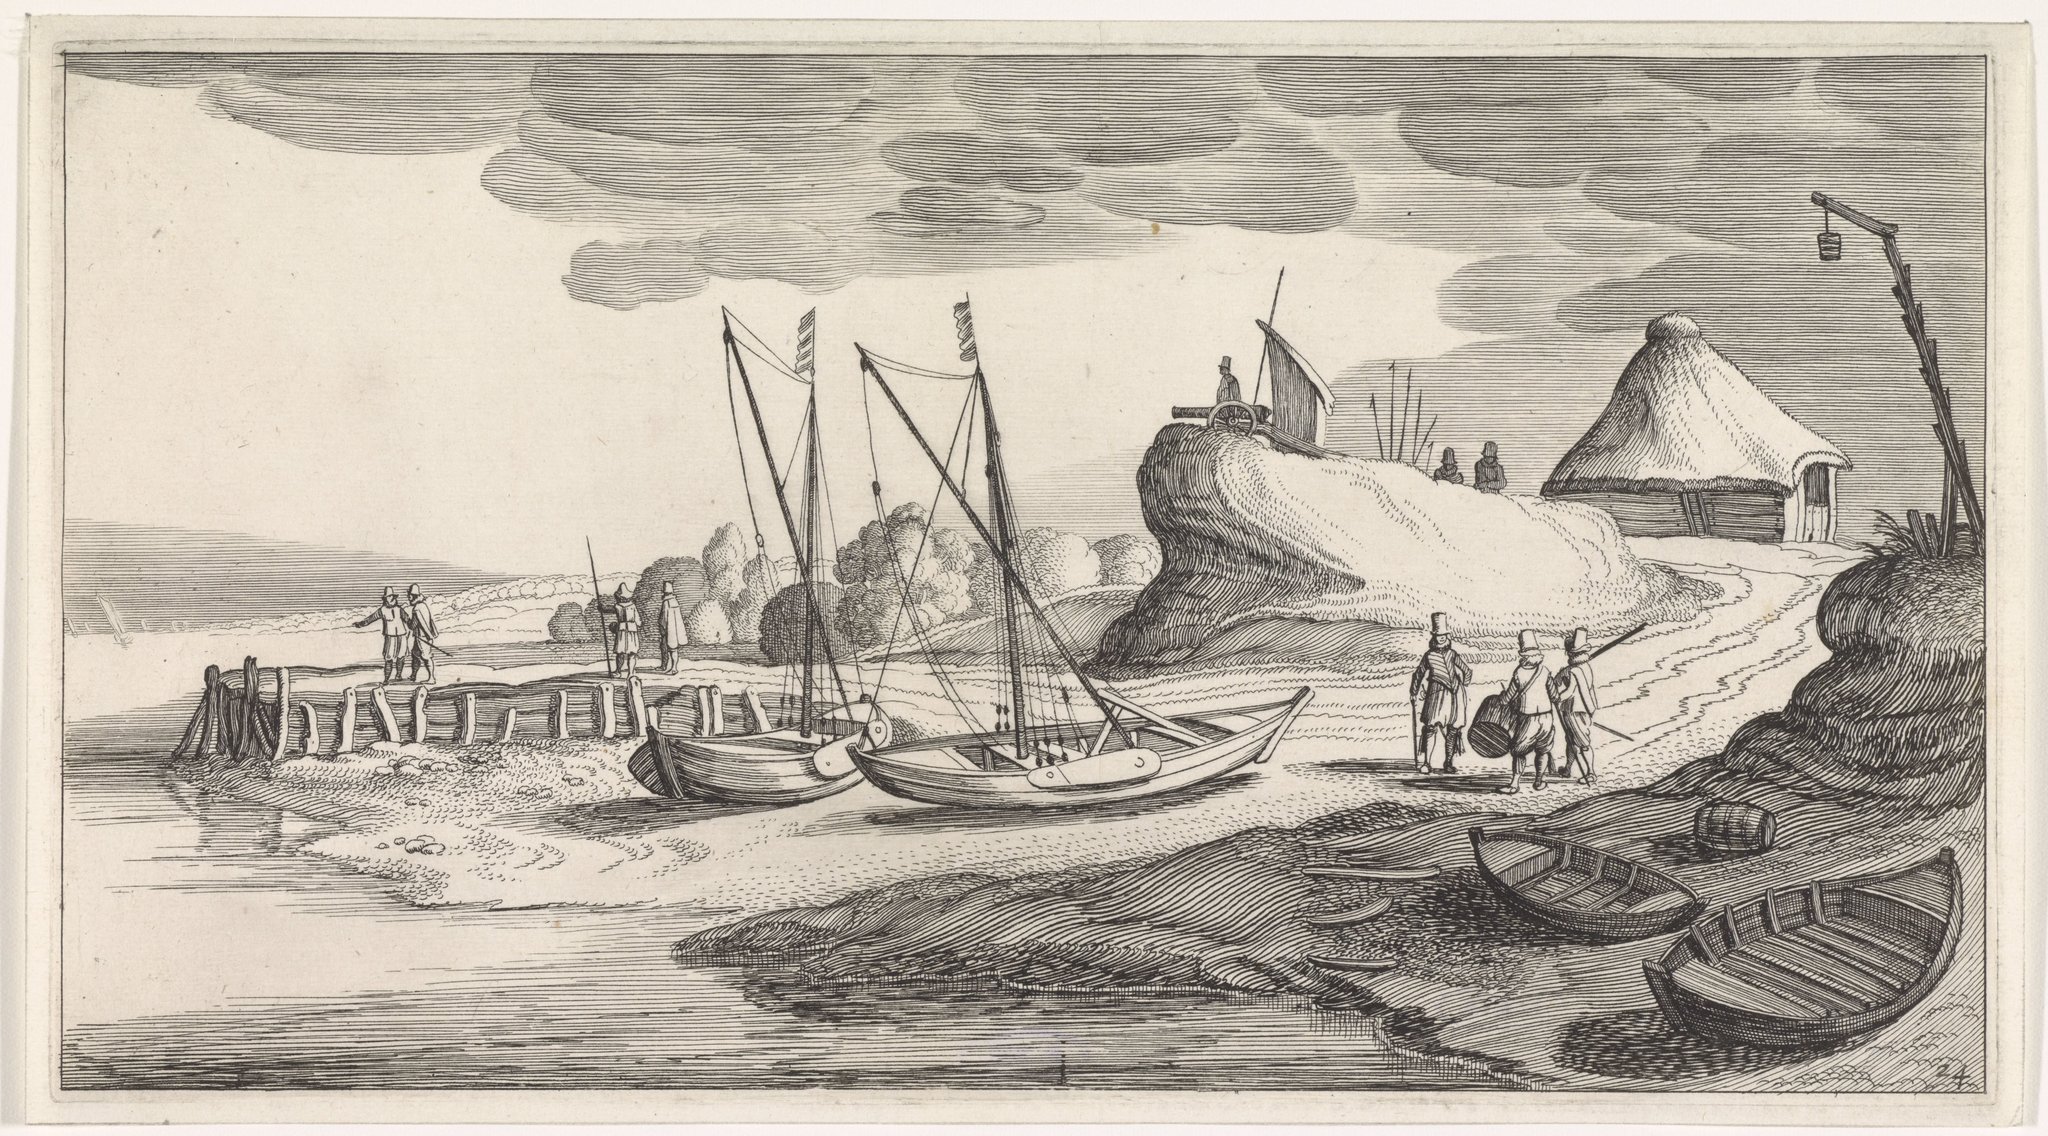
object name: print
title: Playsante lantschappen ende vermakelycke gesichten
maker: jan van de velde (ii)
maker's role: draughtsman, painter, print maker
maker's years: 1593-1641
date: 1639-1641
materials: paper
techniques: etching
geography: northern netherlands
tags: sailing-ship, sailing-boat, river bank, firearms: cannon, the soldier; the soldier's life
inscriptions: collector's mark: Lugt 964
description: Boten op een rivieroever en soldaten op wacht. 24ste prent van een serie met 36 prenten van landschappen, verdeeld over zes delen.